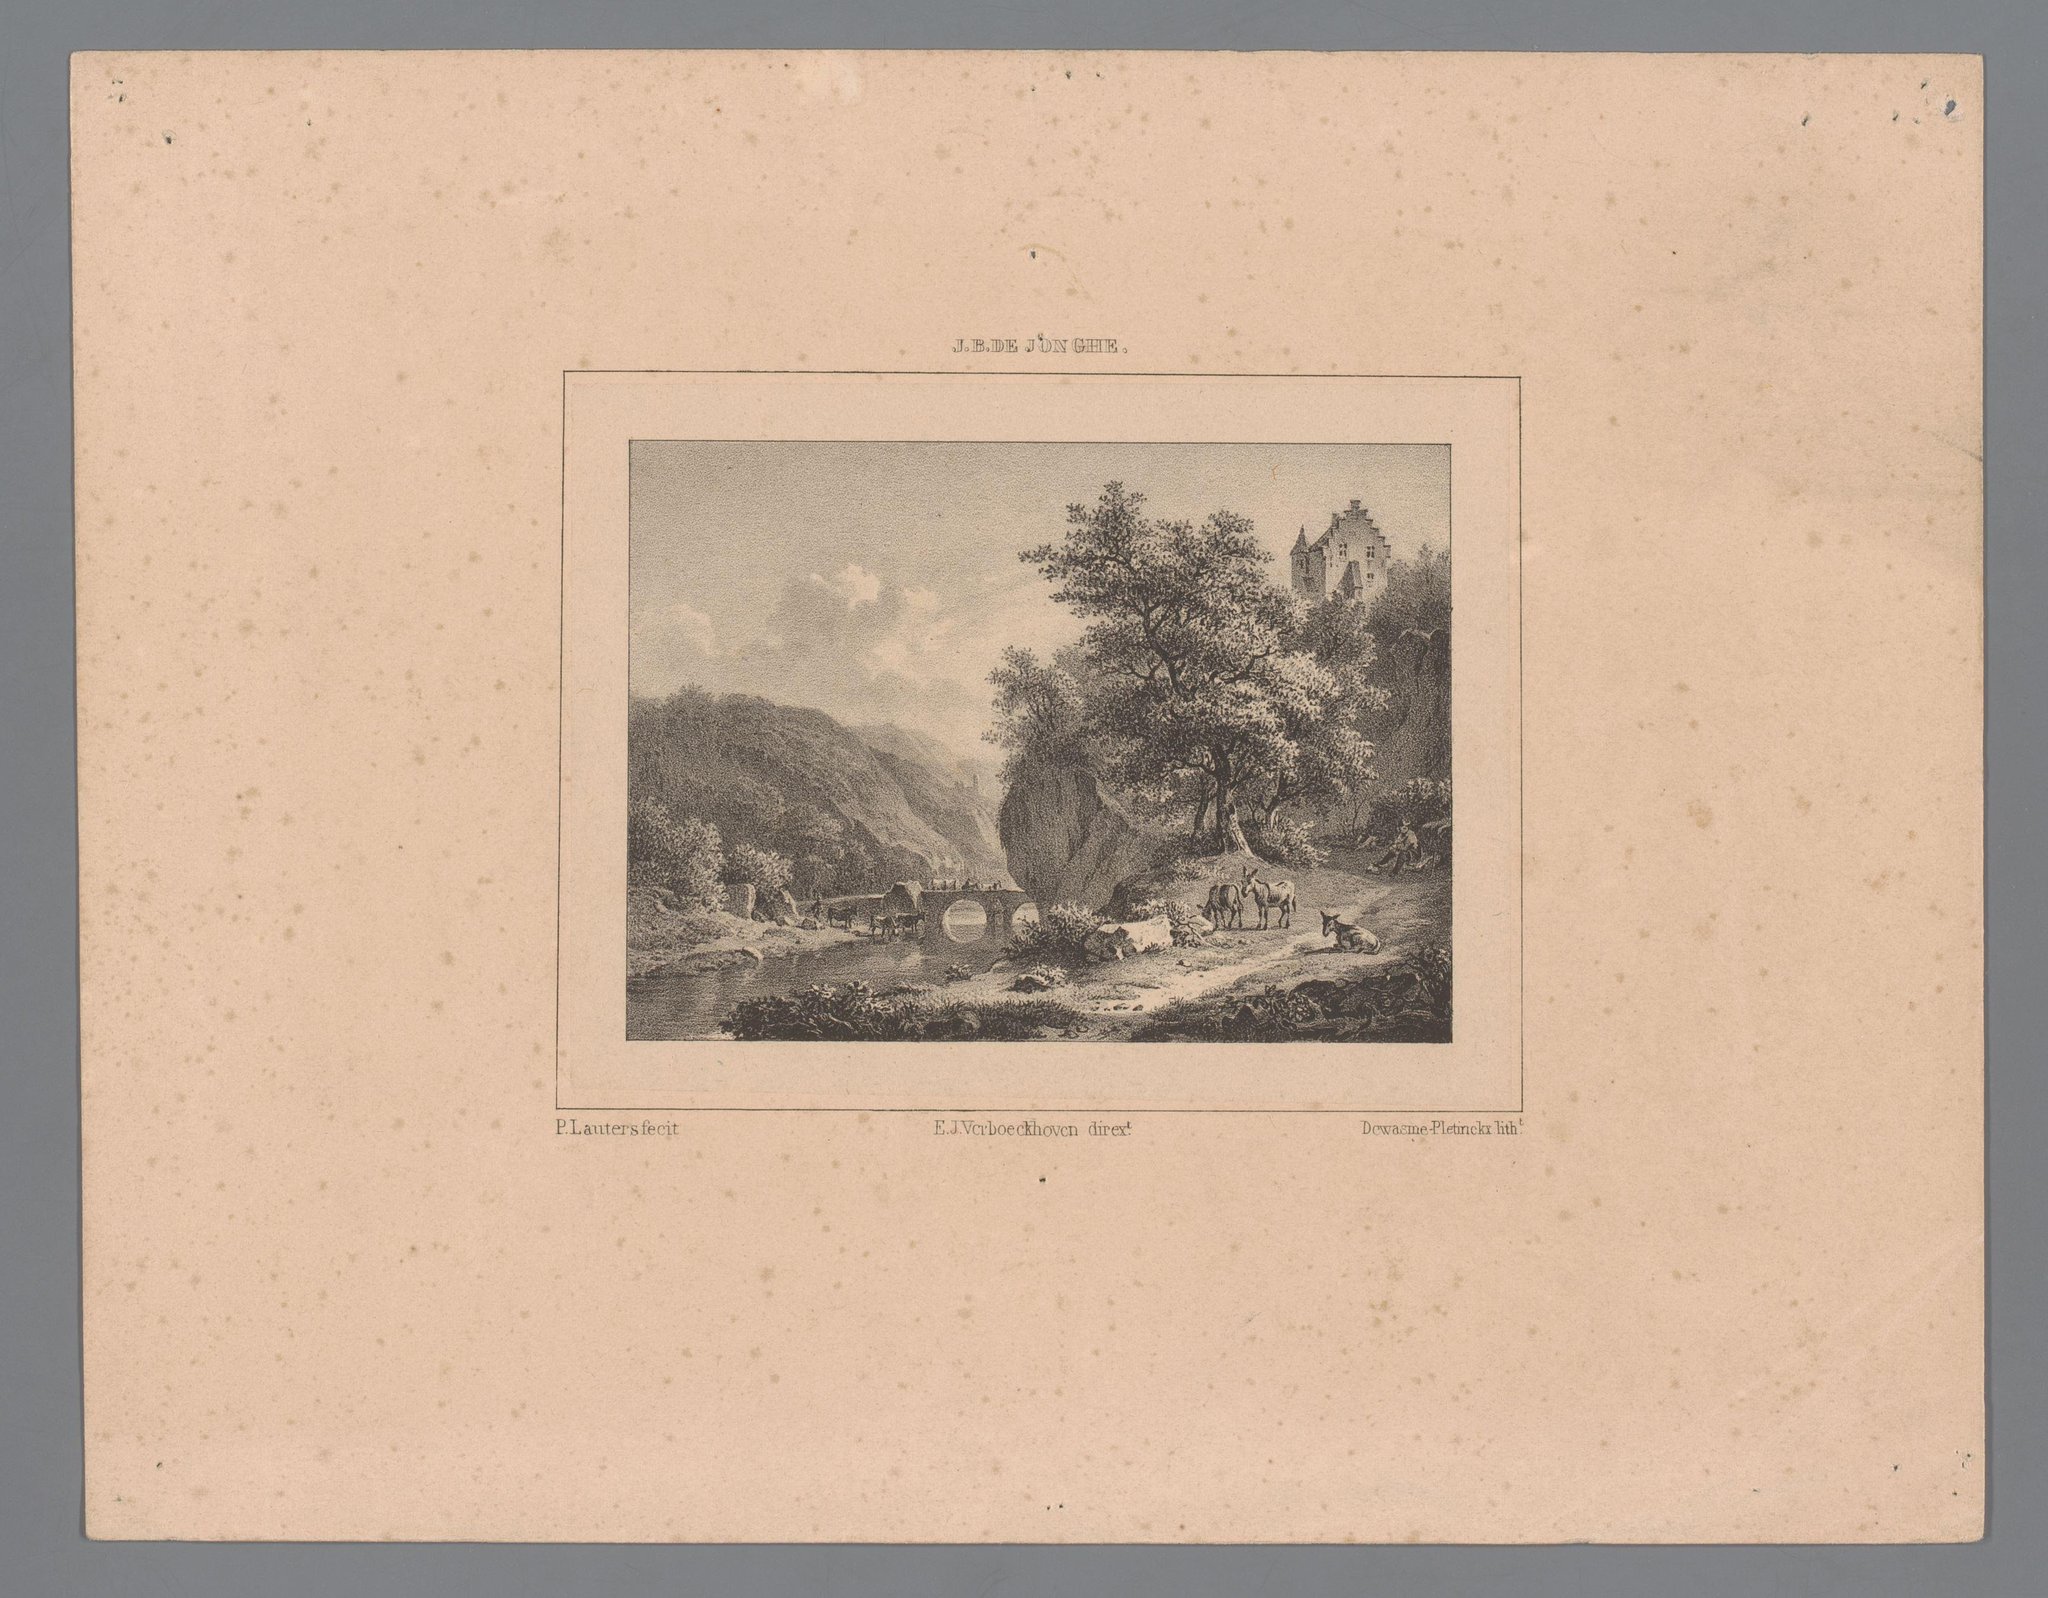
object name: print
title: Album lithographié par Paul Lauters d'après les dessins des principaux peintres du Royaume des Pays-Bas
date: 1829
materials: paper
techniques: lithograph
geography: brussels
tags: ass, donkey, landscape with bridge, viaduct or aqueduct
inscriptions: collector's mark: Lugt 2228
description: Prent verschenen in: Verboeckhoven, Eugène. Album lithographié par Paul Lauters d'après les dessins des principaux peintres du Royaume des Pays-Bas. Brussel: Antoine Dewasme-Pletinckx, 1829.